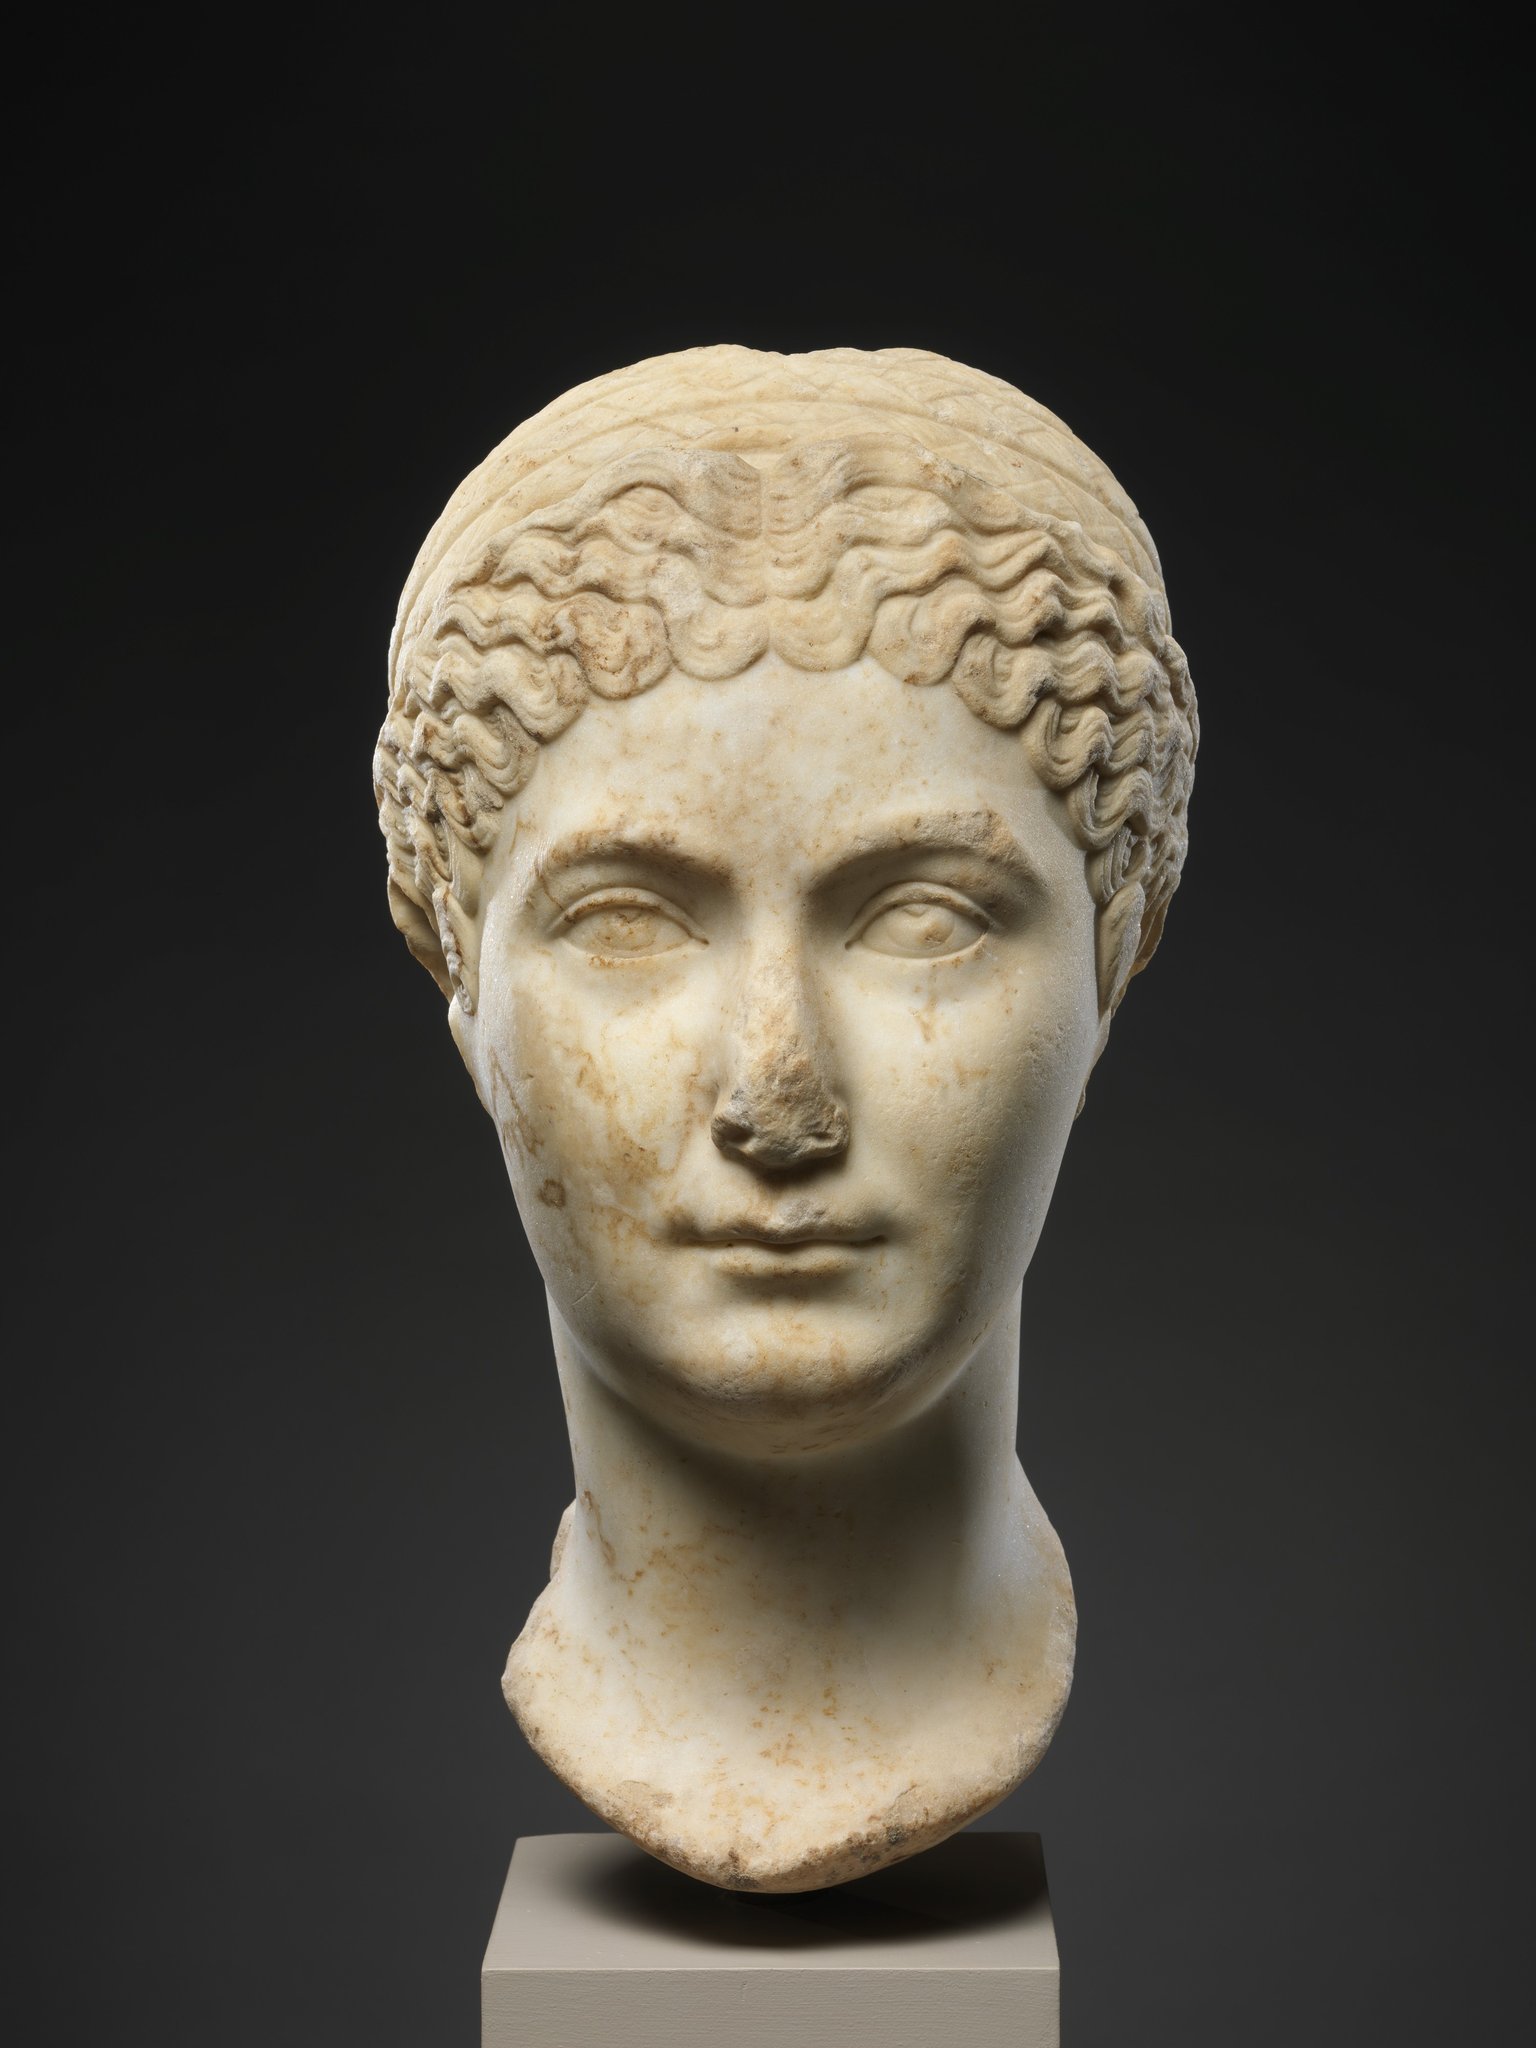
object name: portrait bust of a woman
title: Marble portrait of Matidia Minor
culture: roman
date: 138-161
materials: marble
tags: heads,portraits,women